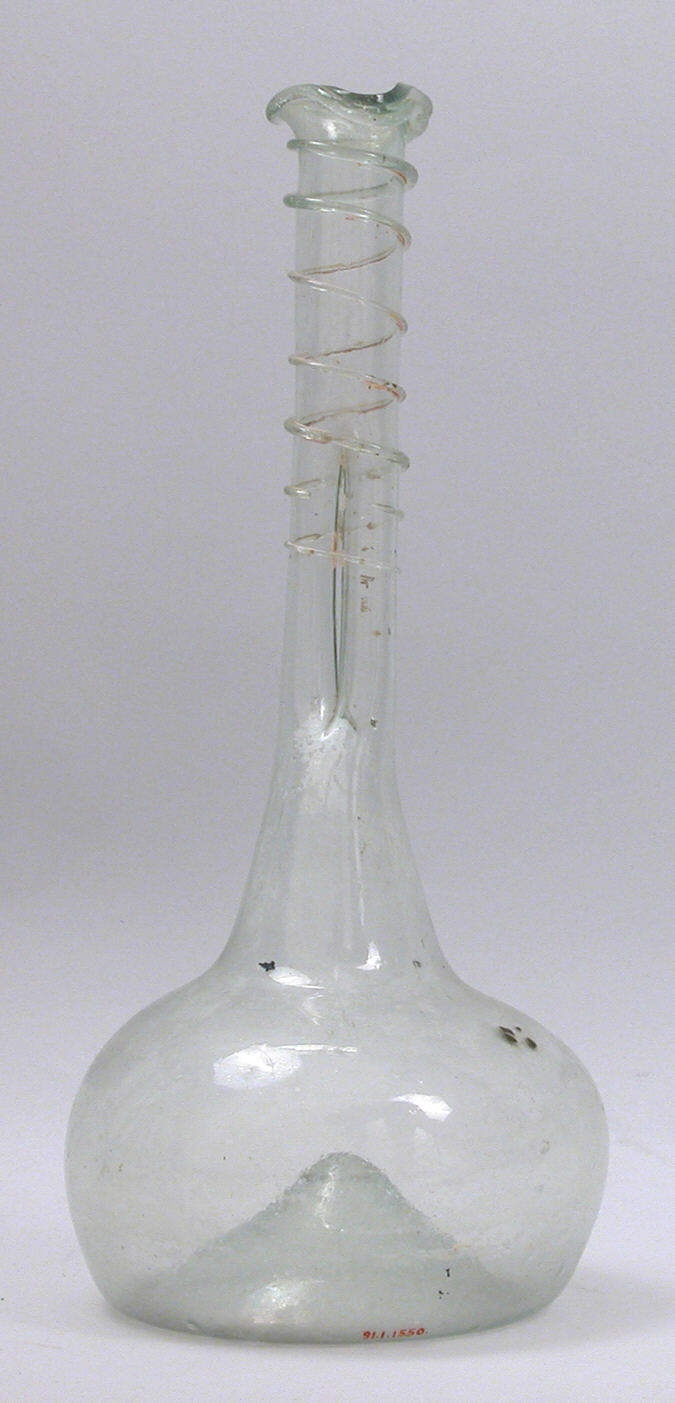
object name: bottle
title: Bottle with a Globular Body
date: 1801-1900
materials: glass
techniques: glassblowing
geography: iran